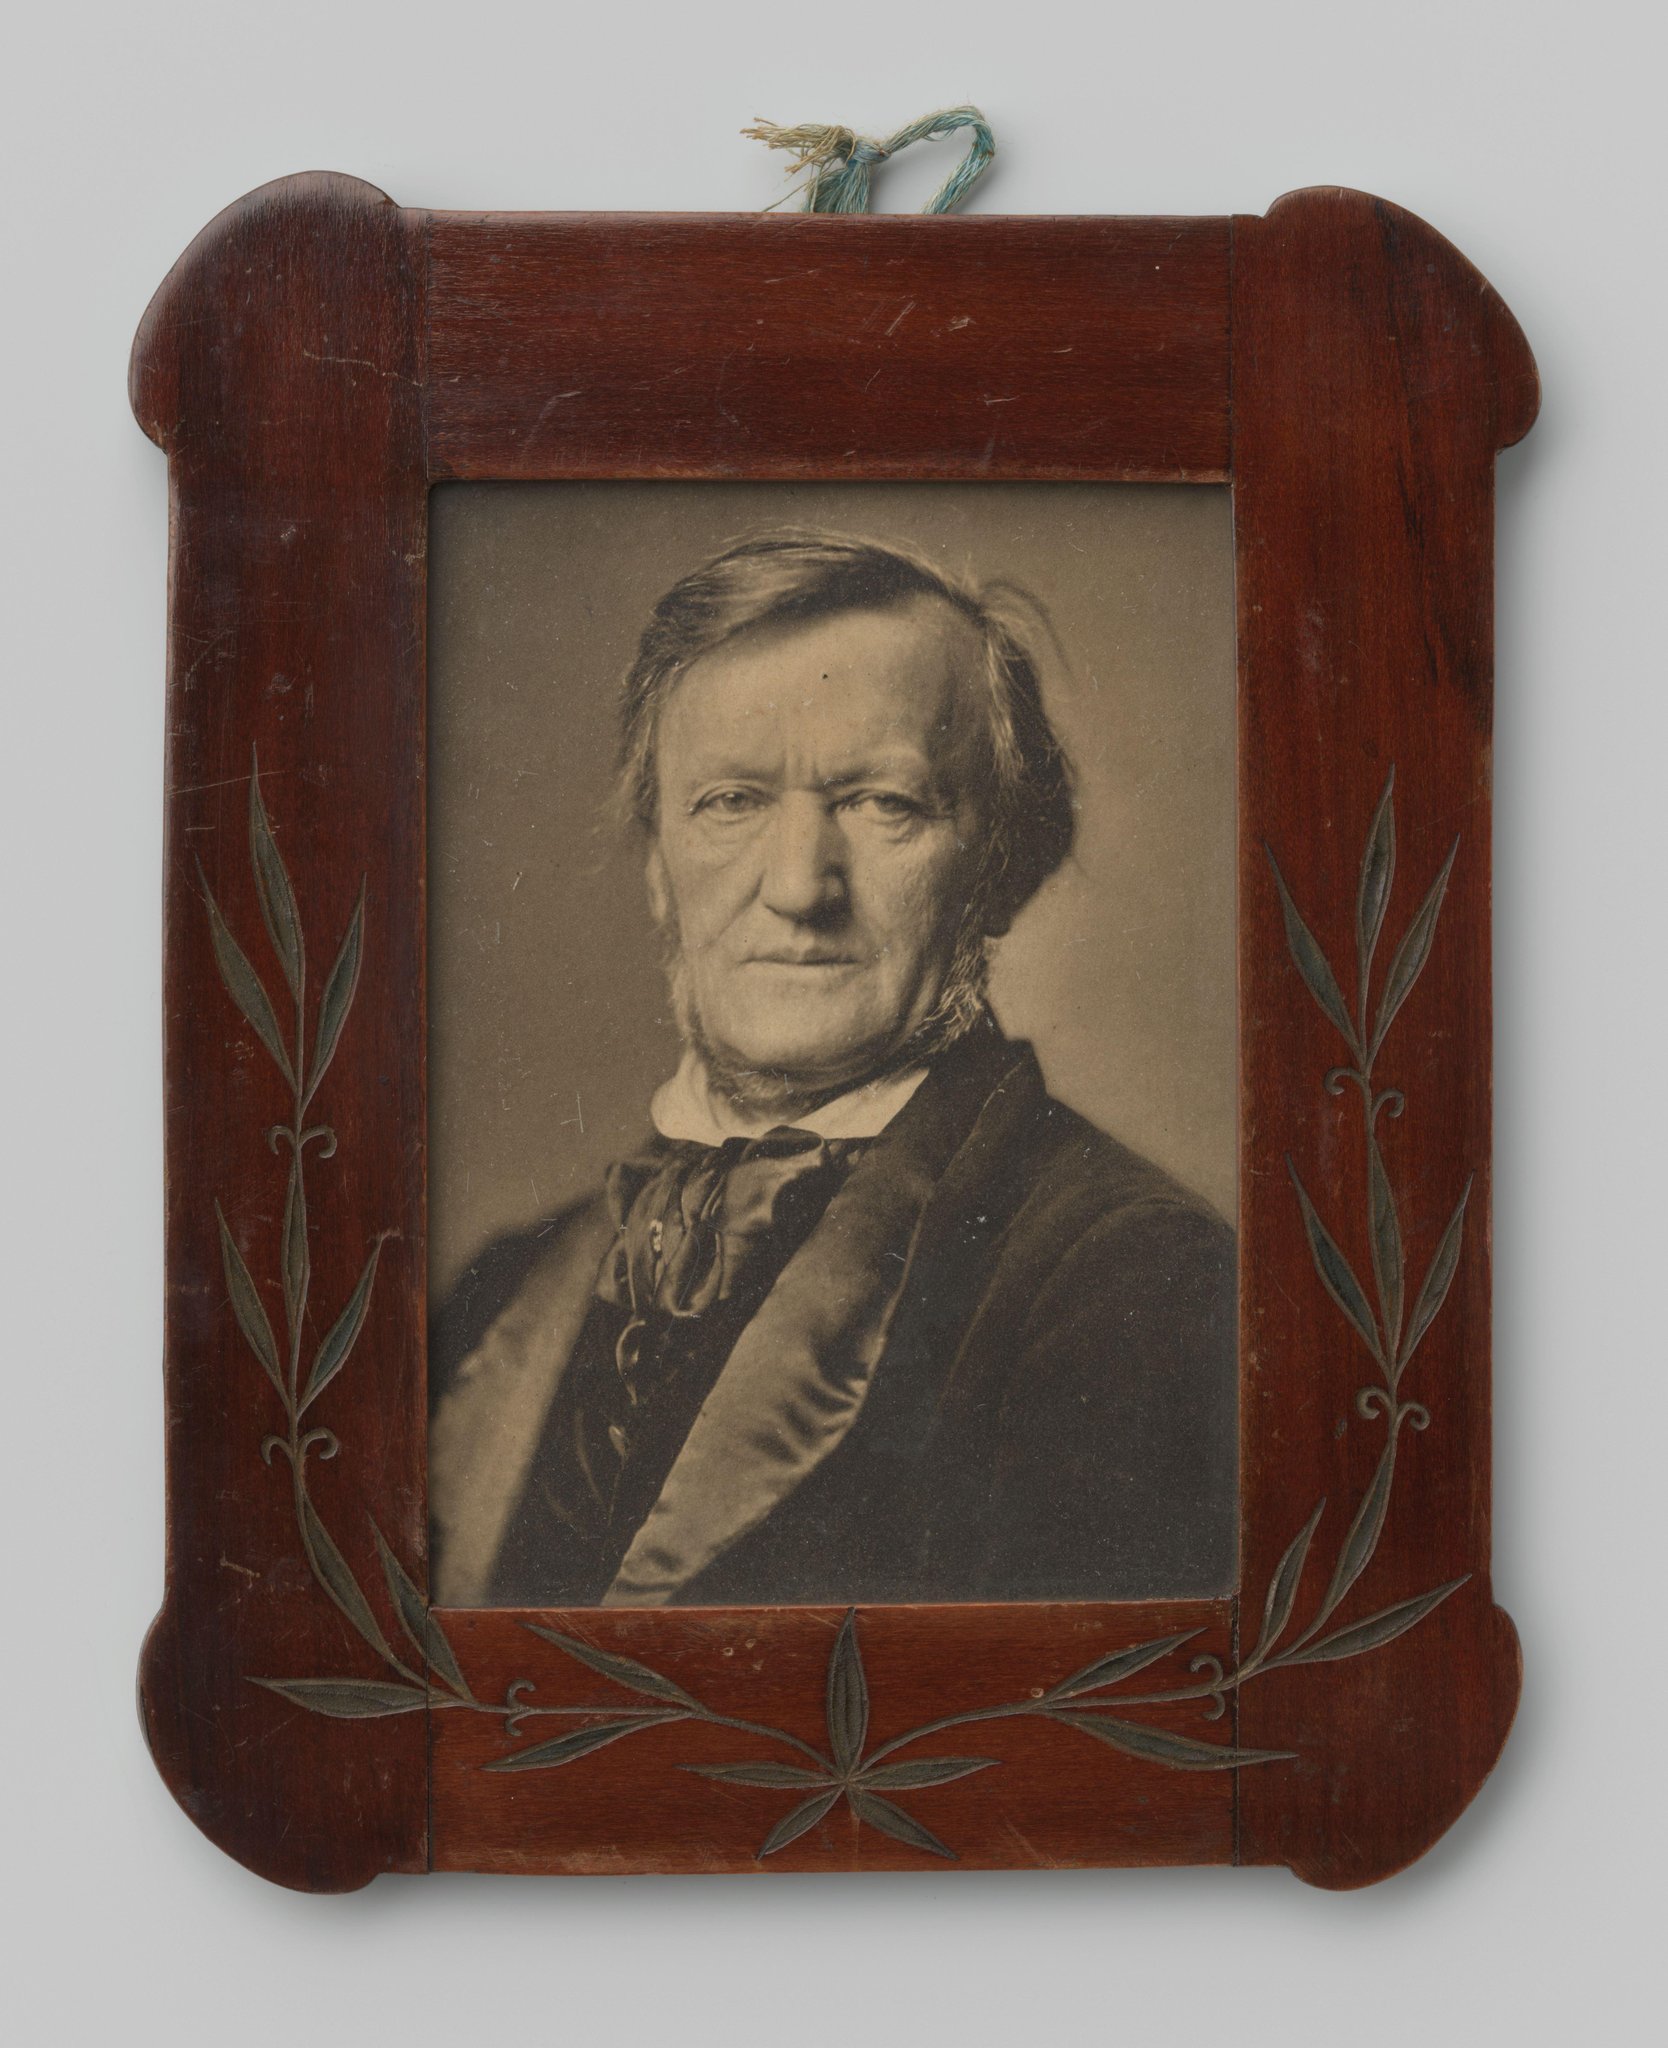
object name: frame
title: Portret van Richard Wagner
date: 1871-1883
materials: cardboard, glass, metal, paper, fiber, wood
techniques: photoaquatint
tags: richard wagner, portrait of composer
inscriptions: number: ‘30320’, label: ‘H.N.B.’, inscription: ‘R. Wagner’